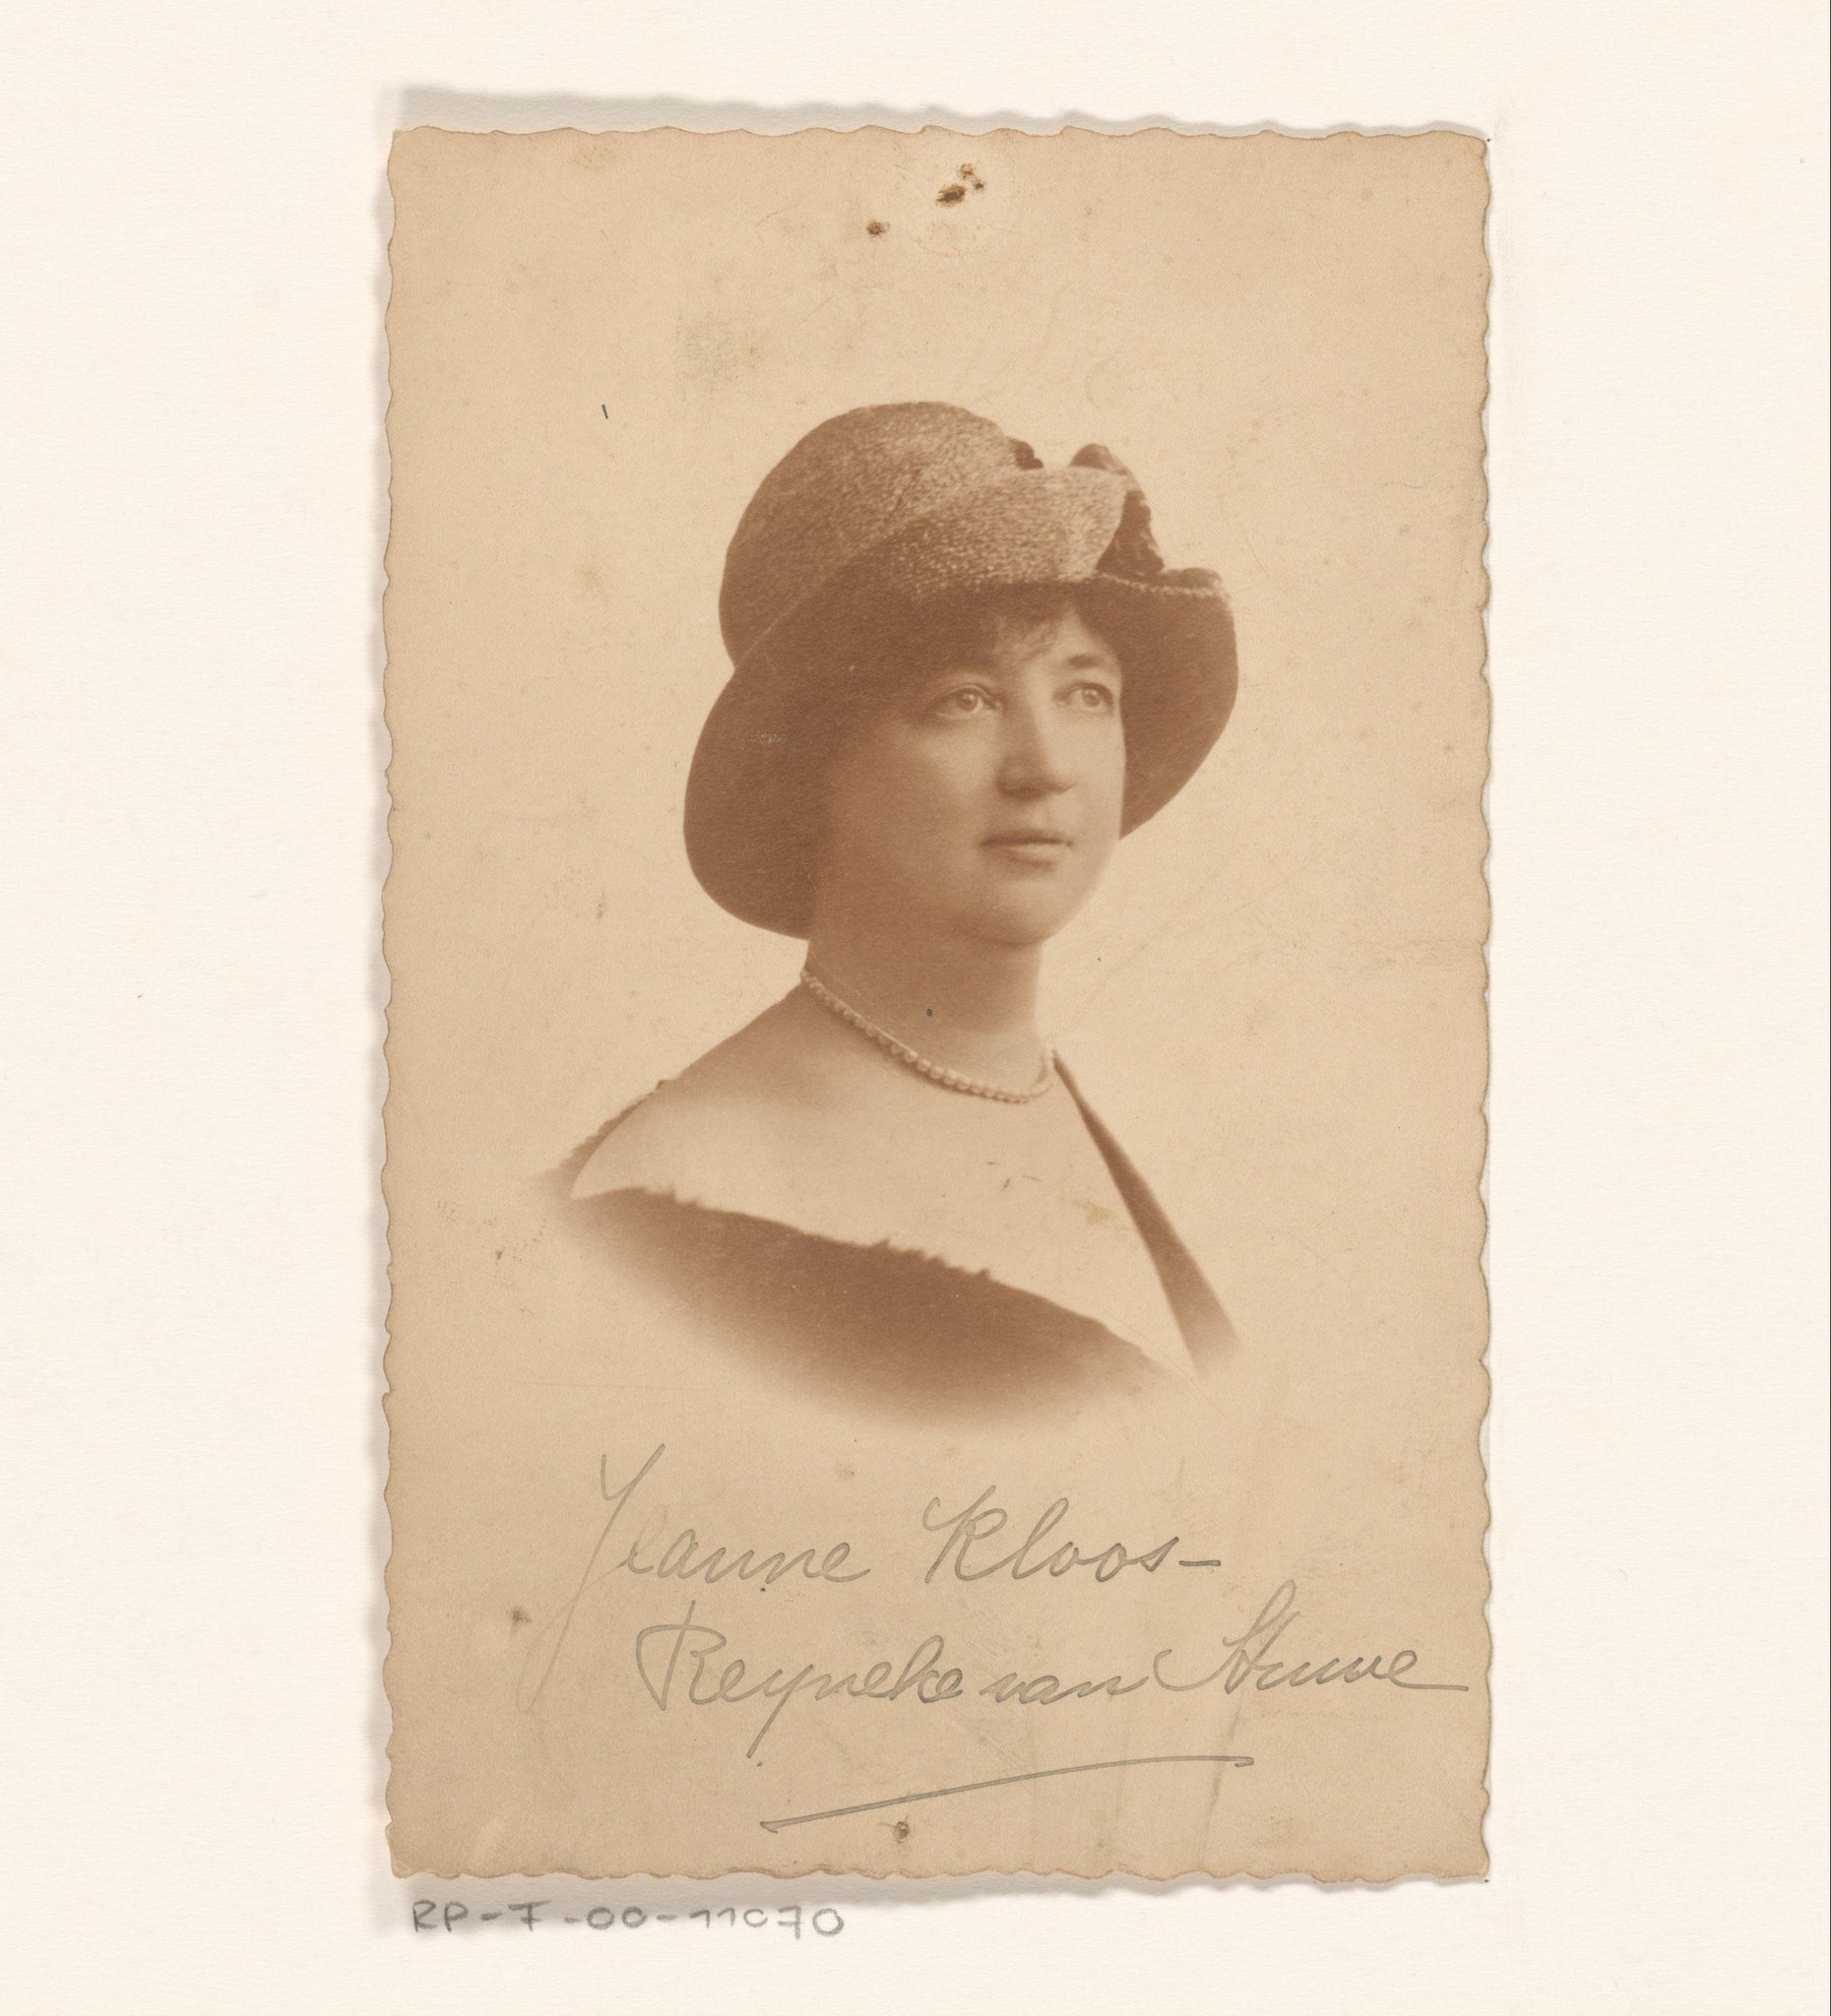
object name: photograph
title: Portret van Jeanne Henriette Reine Reyneke van Stuwe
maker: Anonymous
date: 1890-1920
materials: photographic support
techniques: matte daylight collodion silver print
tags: the hague, jeanne henriette reine reyneke van stuwe, writer, poet, author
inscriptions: annotation: ‘In hartelijken dank voor/ de vriendelijke deelname/ aan de heerlijke verrassing/ mij op 4 Januari bereid.’, name: ‘Jeanne Kloos-/ Reyneke van Stuwe’, collector's mark: Lugt 2228a, :